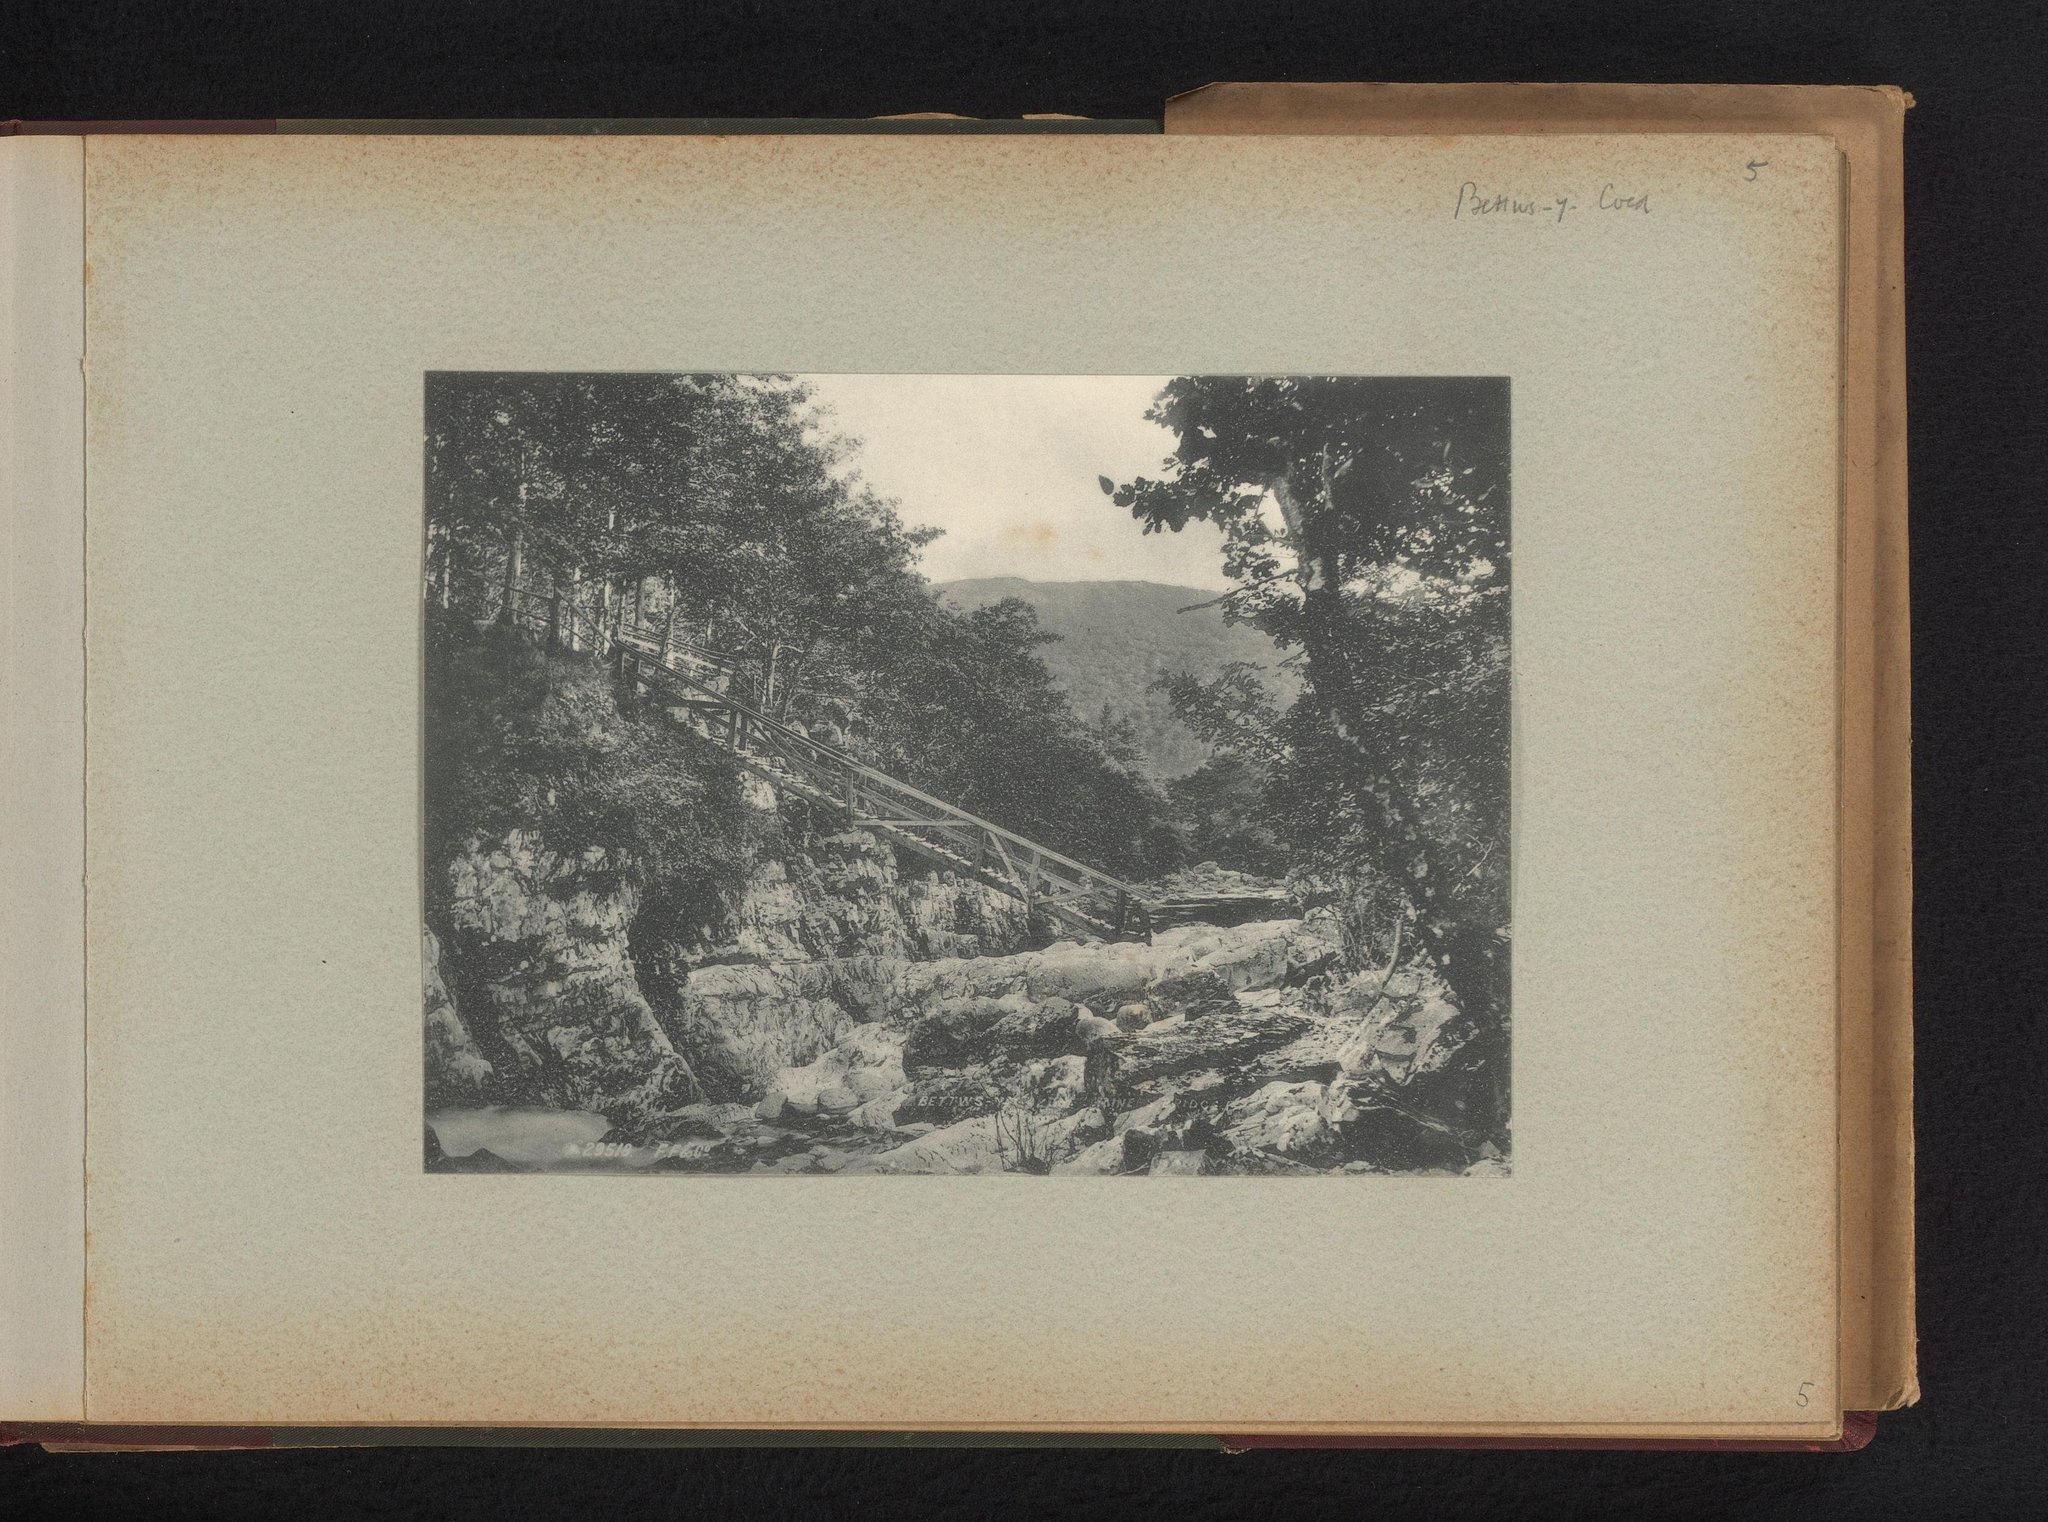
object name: photomechanical print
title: Betws-y-Coed. The Miner's Bridge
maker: Anonymous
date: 1880-1900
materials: paper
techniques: photograph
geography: bettws-y-coed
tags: brook, bridge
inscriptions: number: ‘29519.’, inscription: ‘Betwys-y-Coed/ 5’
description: Deze prent maakt deel uit van een album.